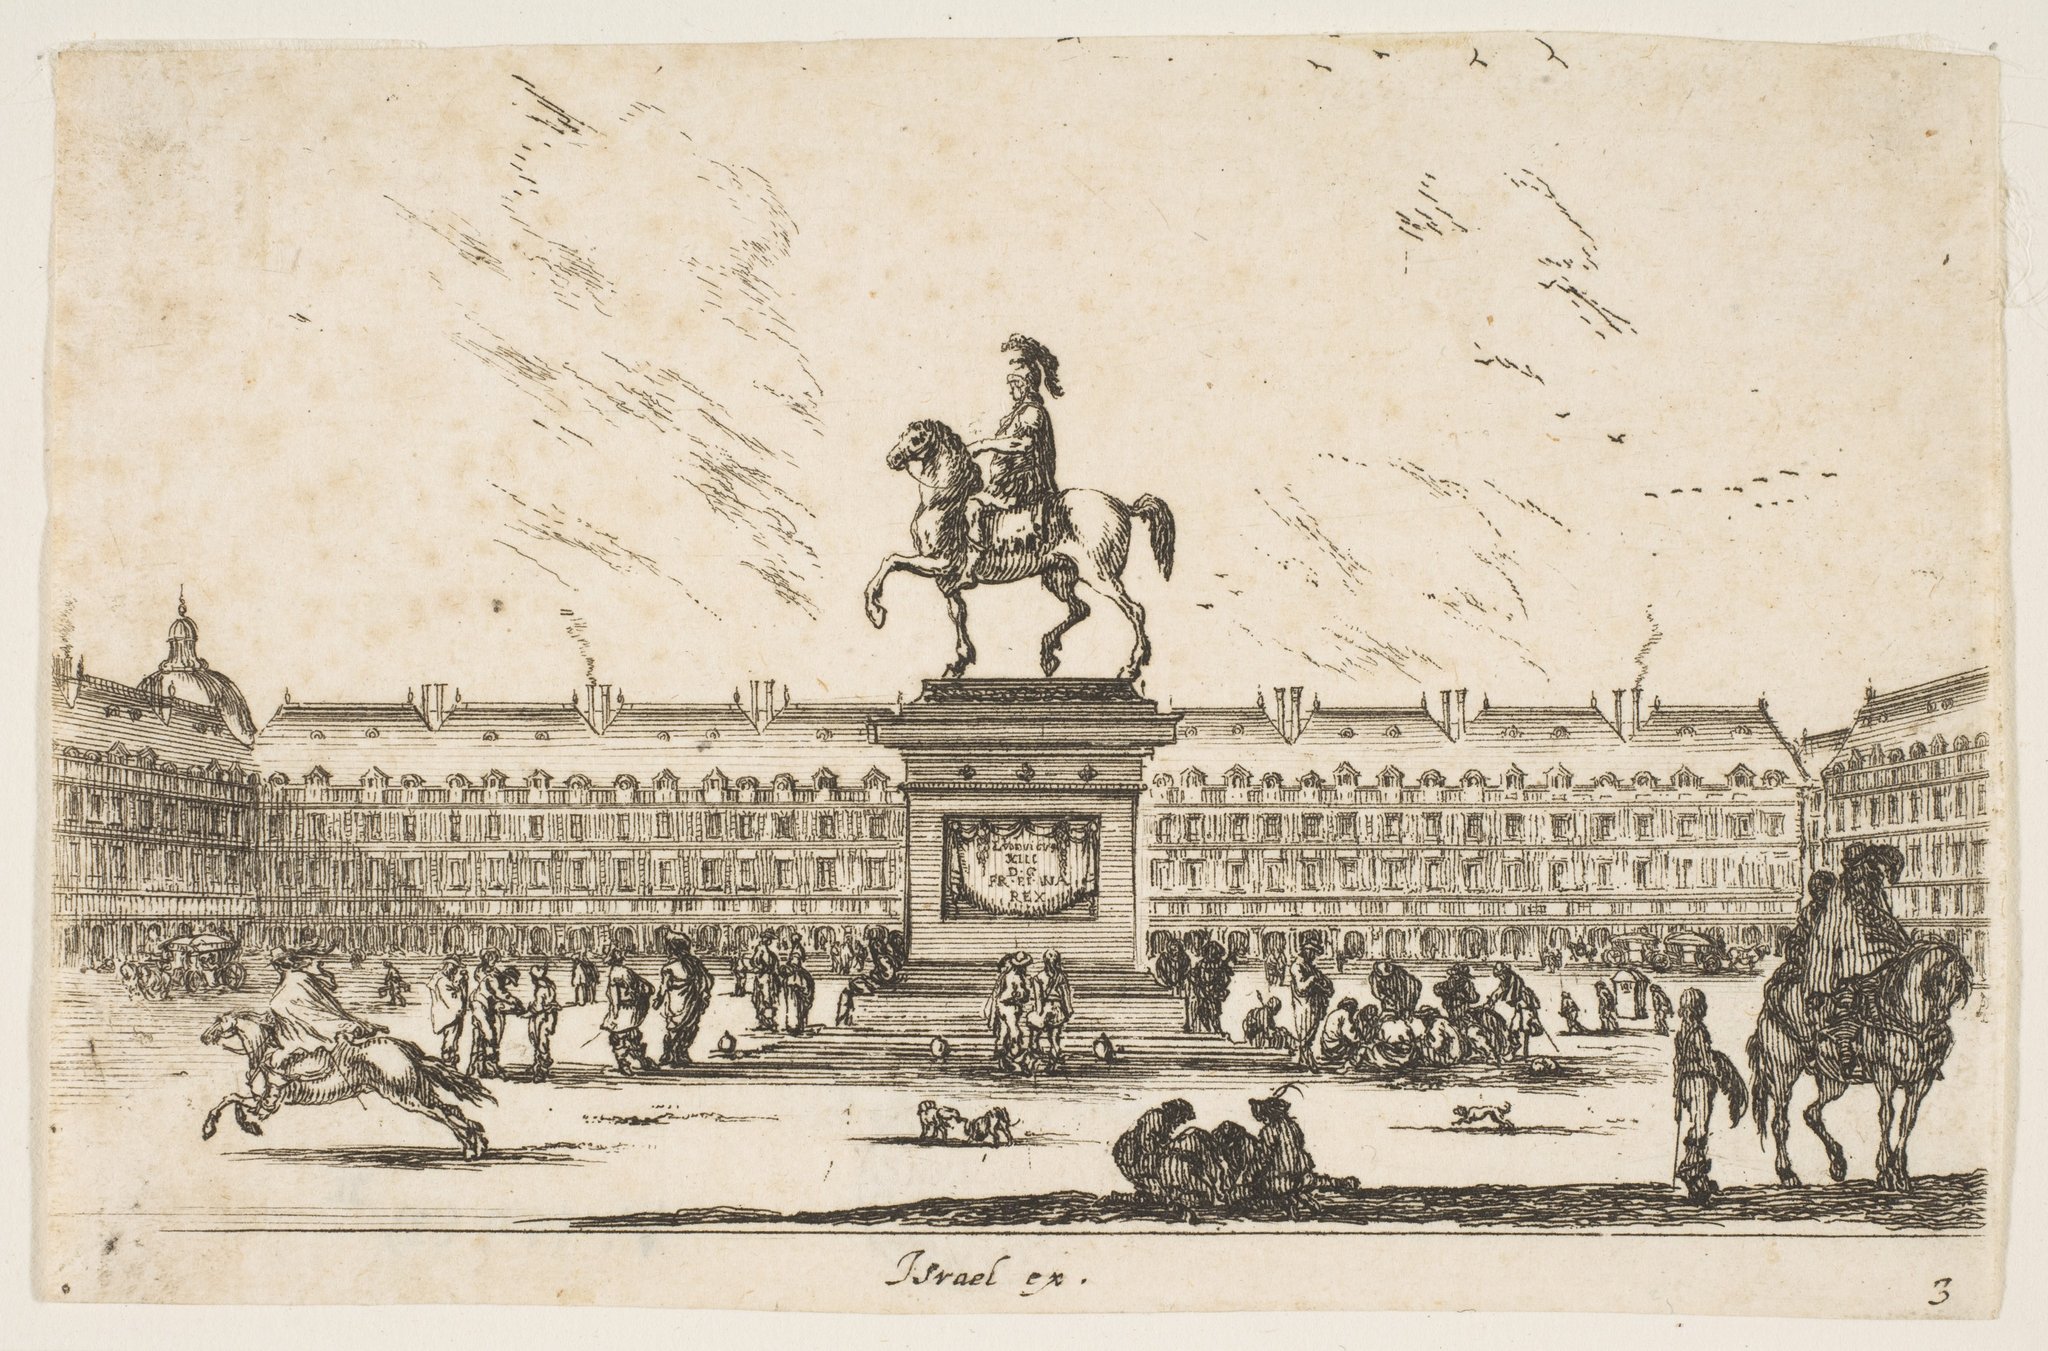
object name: print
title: La Place Royale, equestrian statue of Louis XIII in profile facing the left in center, various horsemen and figures in background, plate 3 from "Various Figures" (Agréable diversité de figures)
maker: stefano della bella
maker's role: artist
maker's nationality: italian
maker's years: 1610-1664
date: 1642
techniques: etching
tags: buildings,monuments,horses,paris